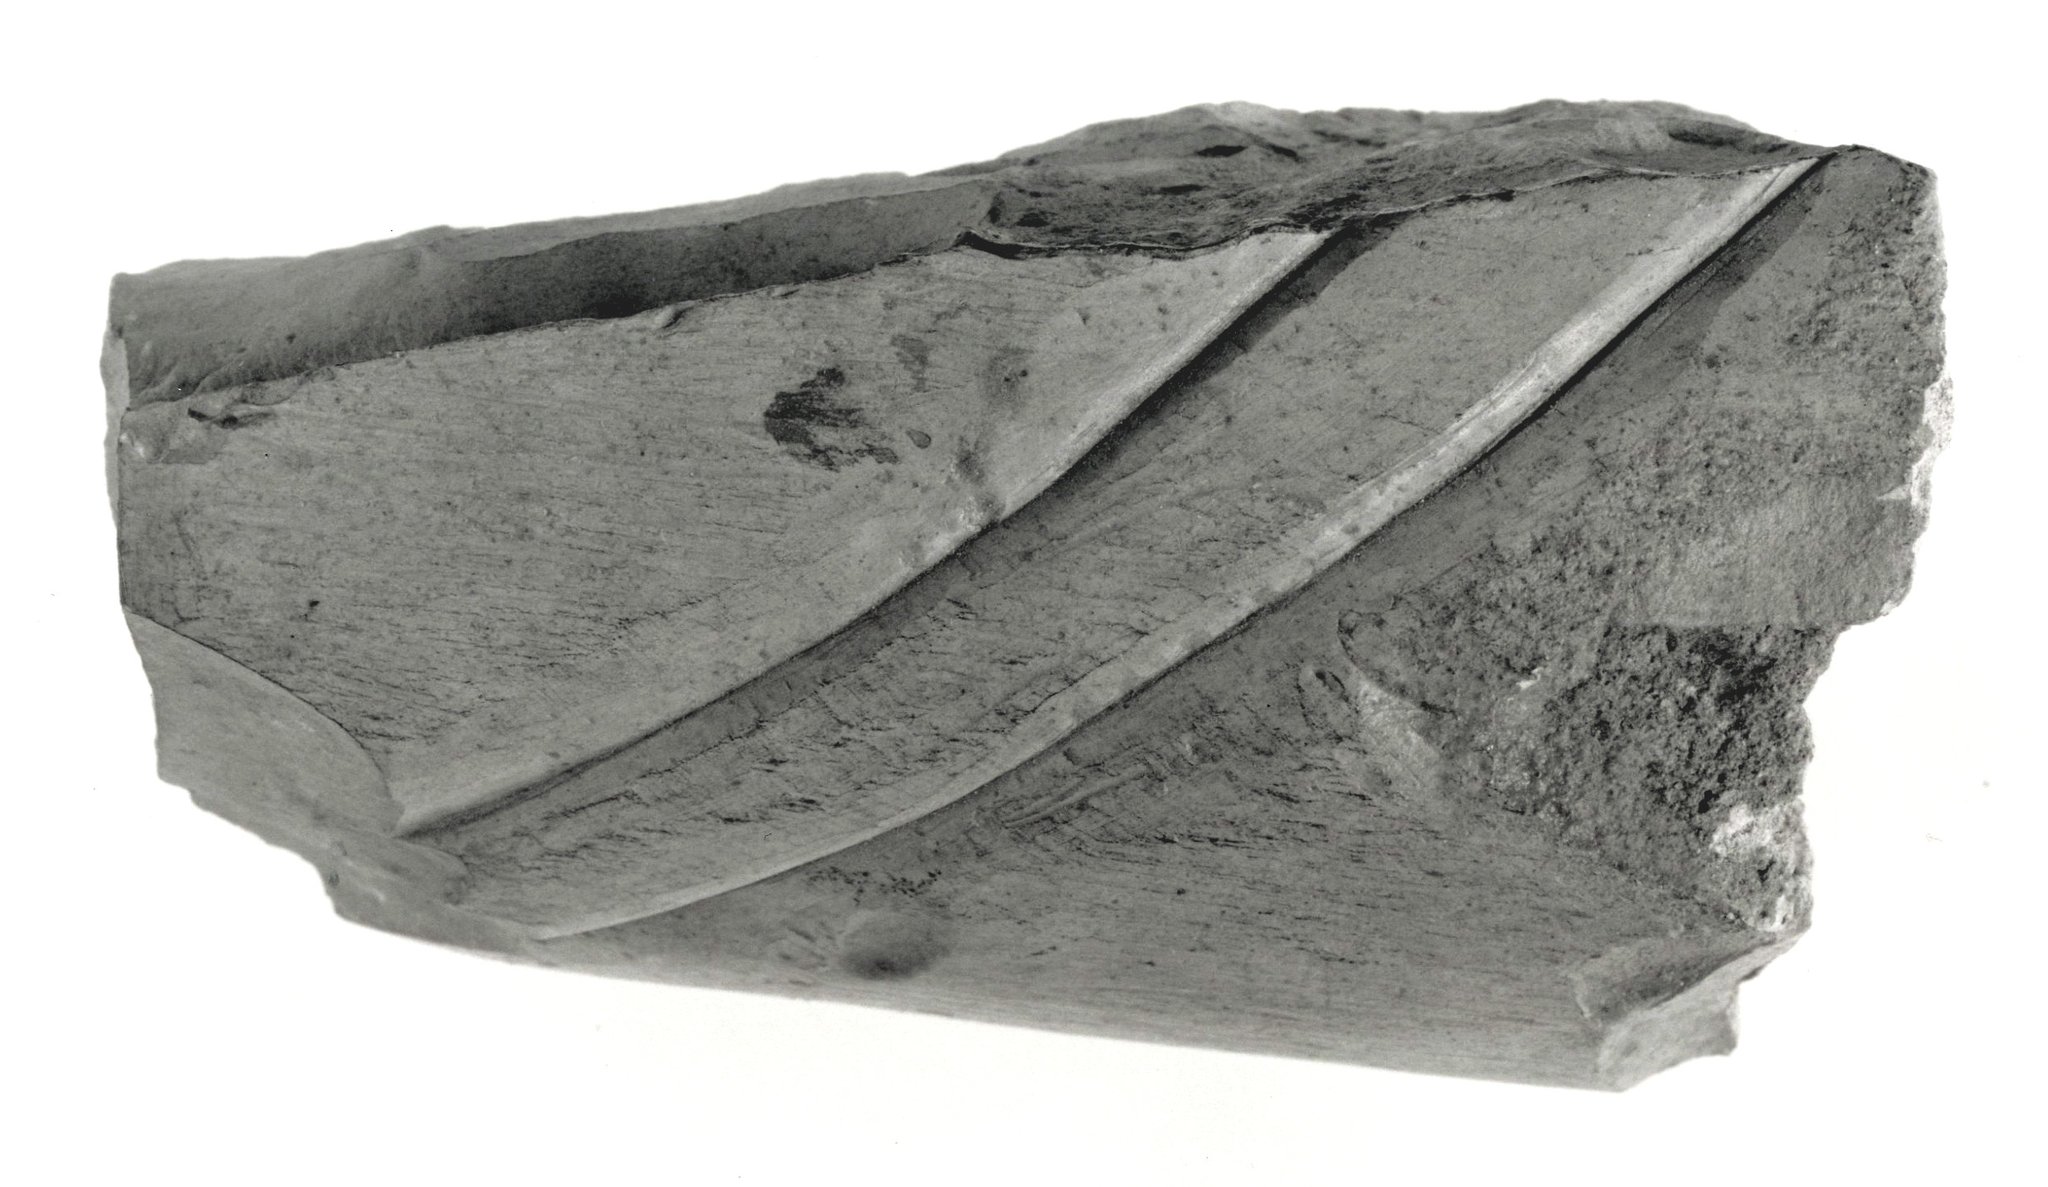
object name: relief, tomb of nespekashuty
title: Raised relief fragment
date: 664-610 BCE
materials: limestone, varnish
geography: egypt